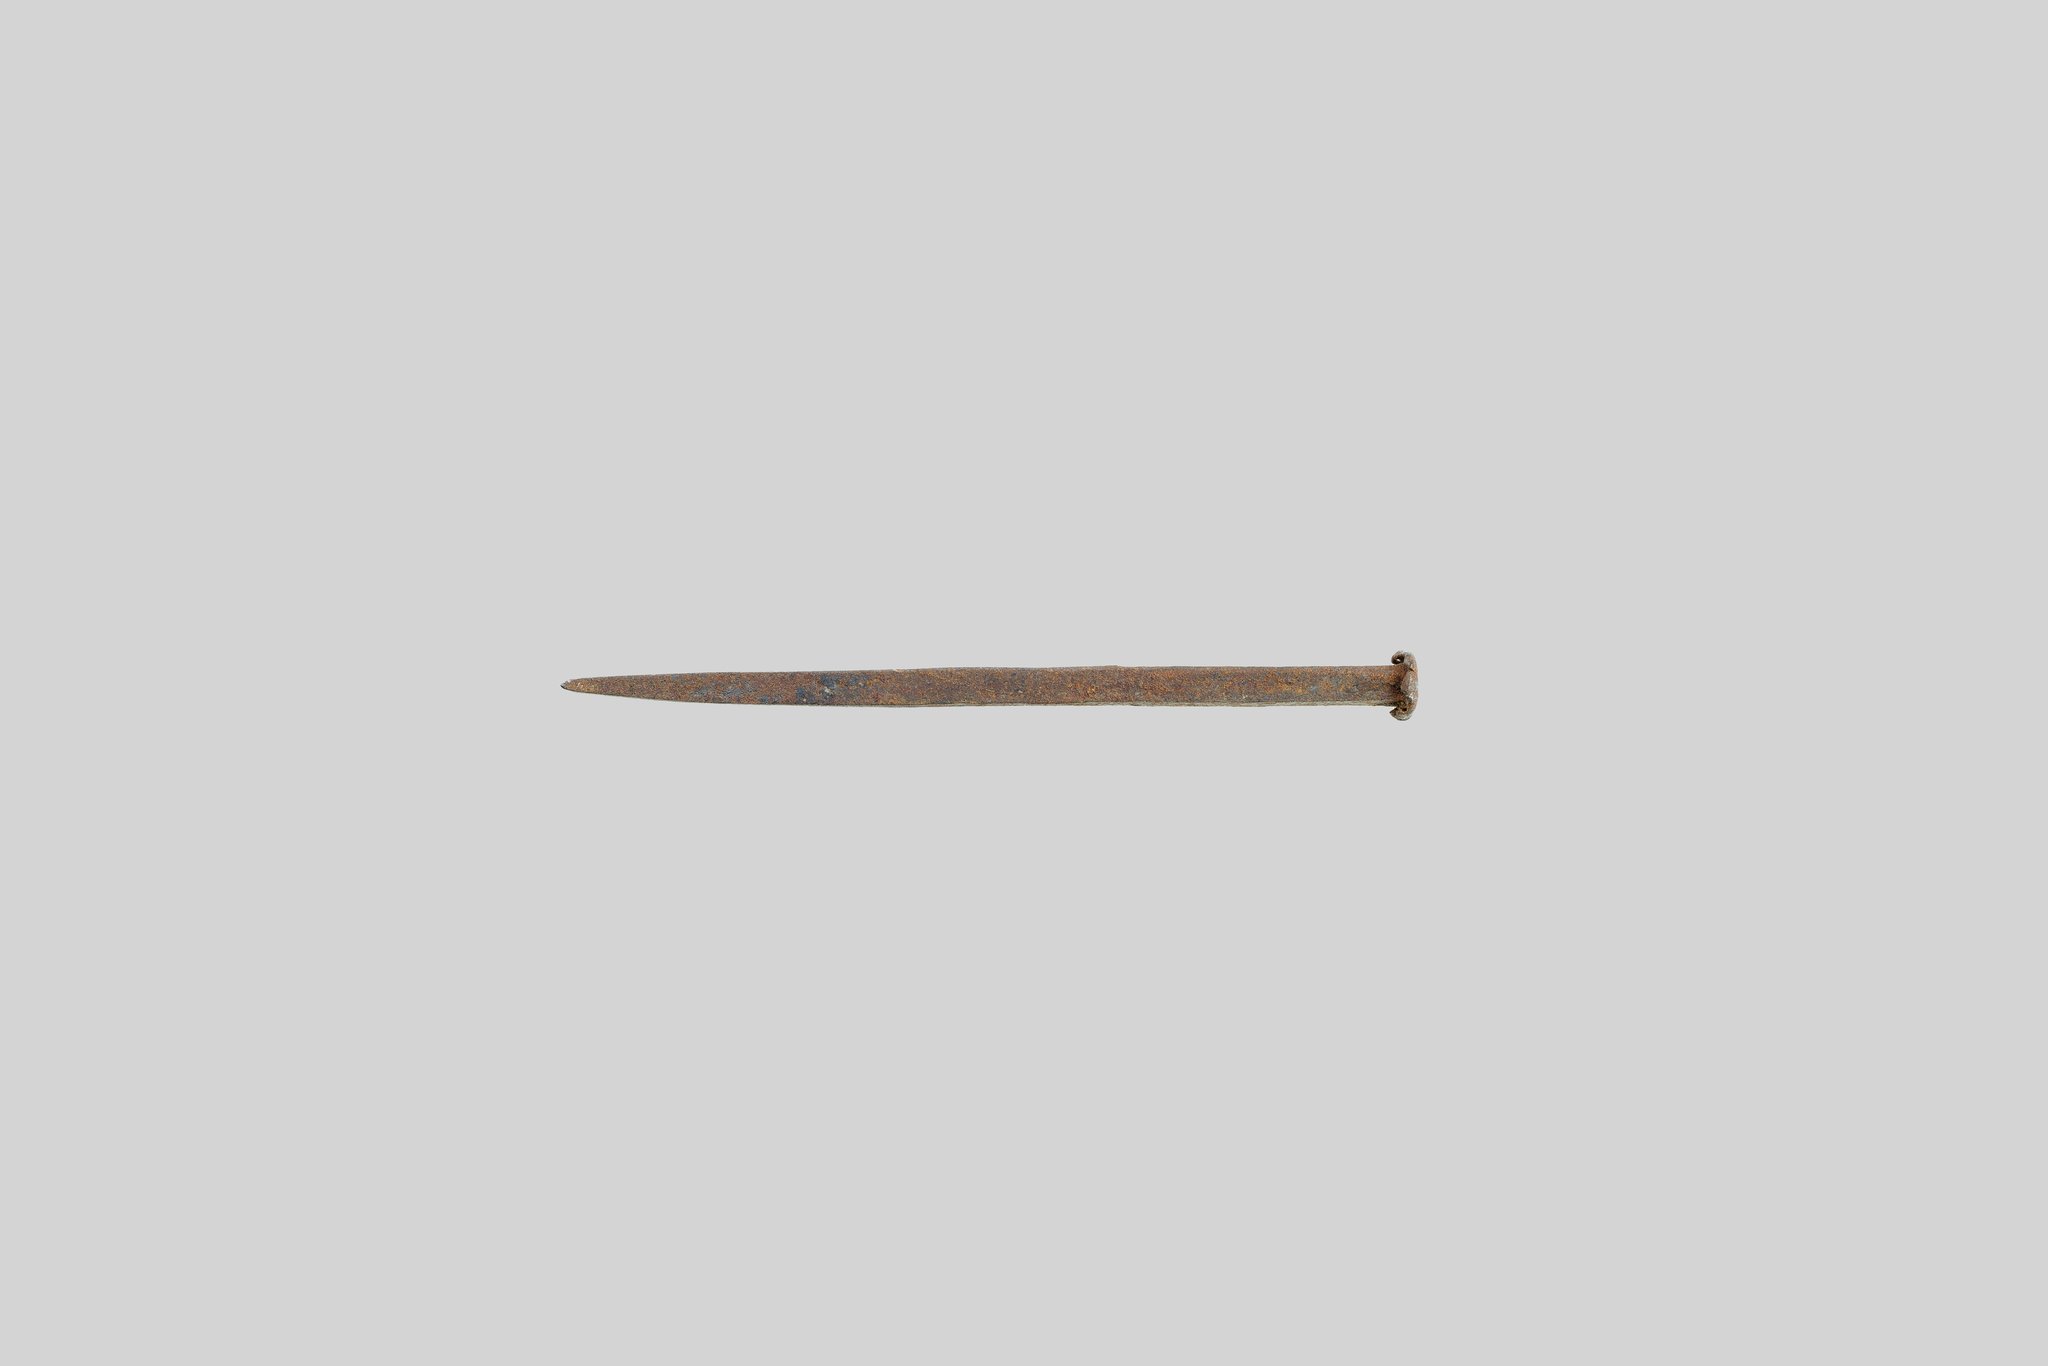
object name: chisel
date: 1070-525 BCE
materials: iron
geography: egypt